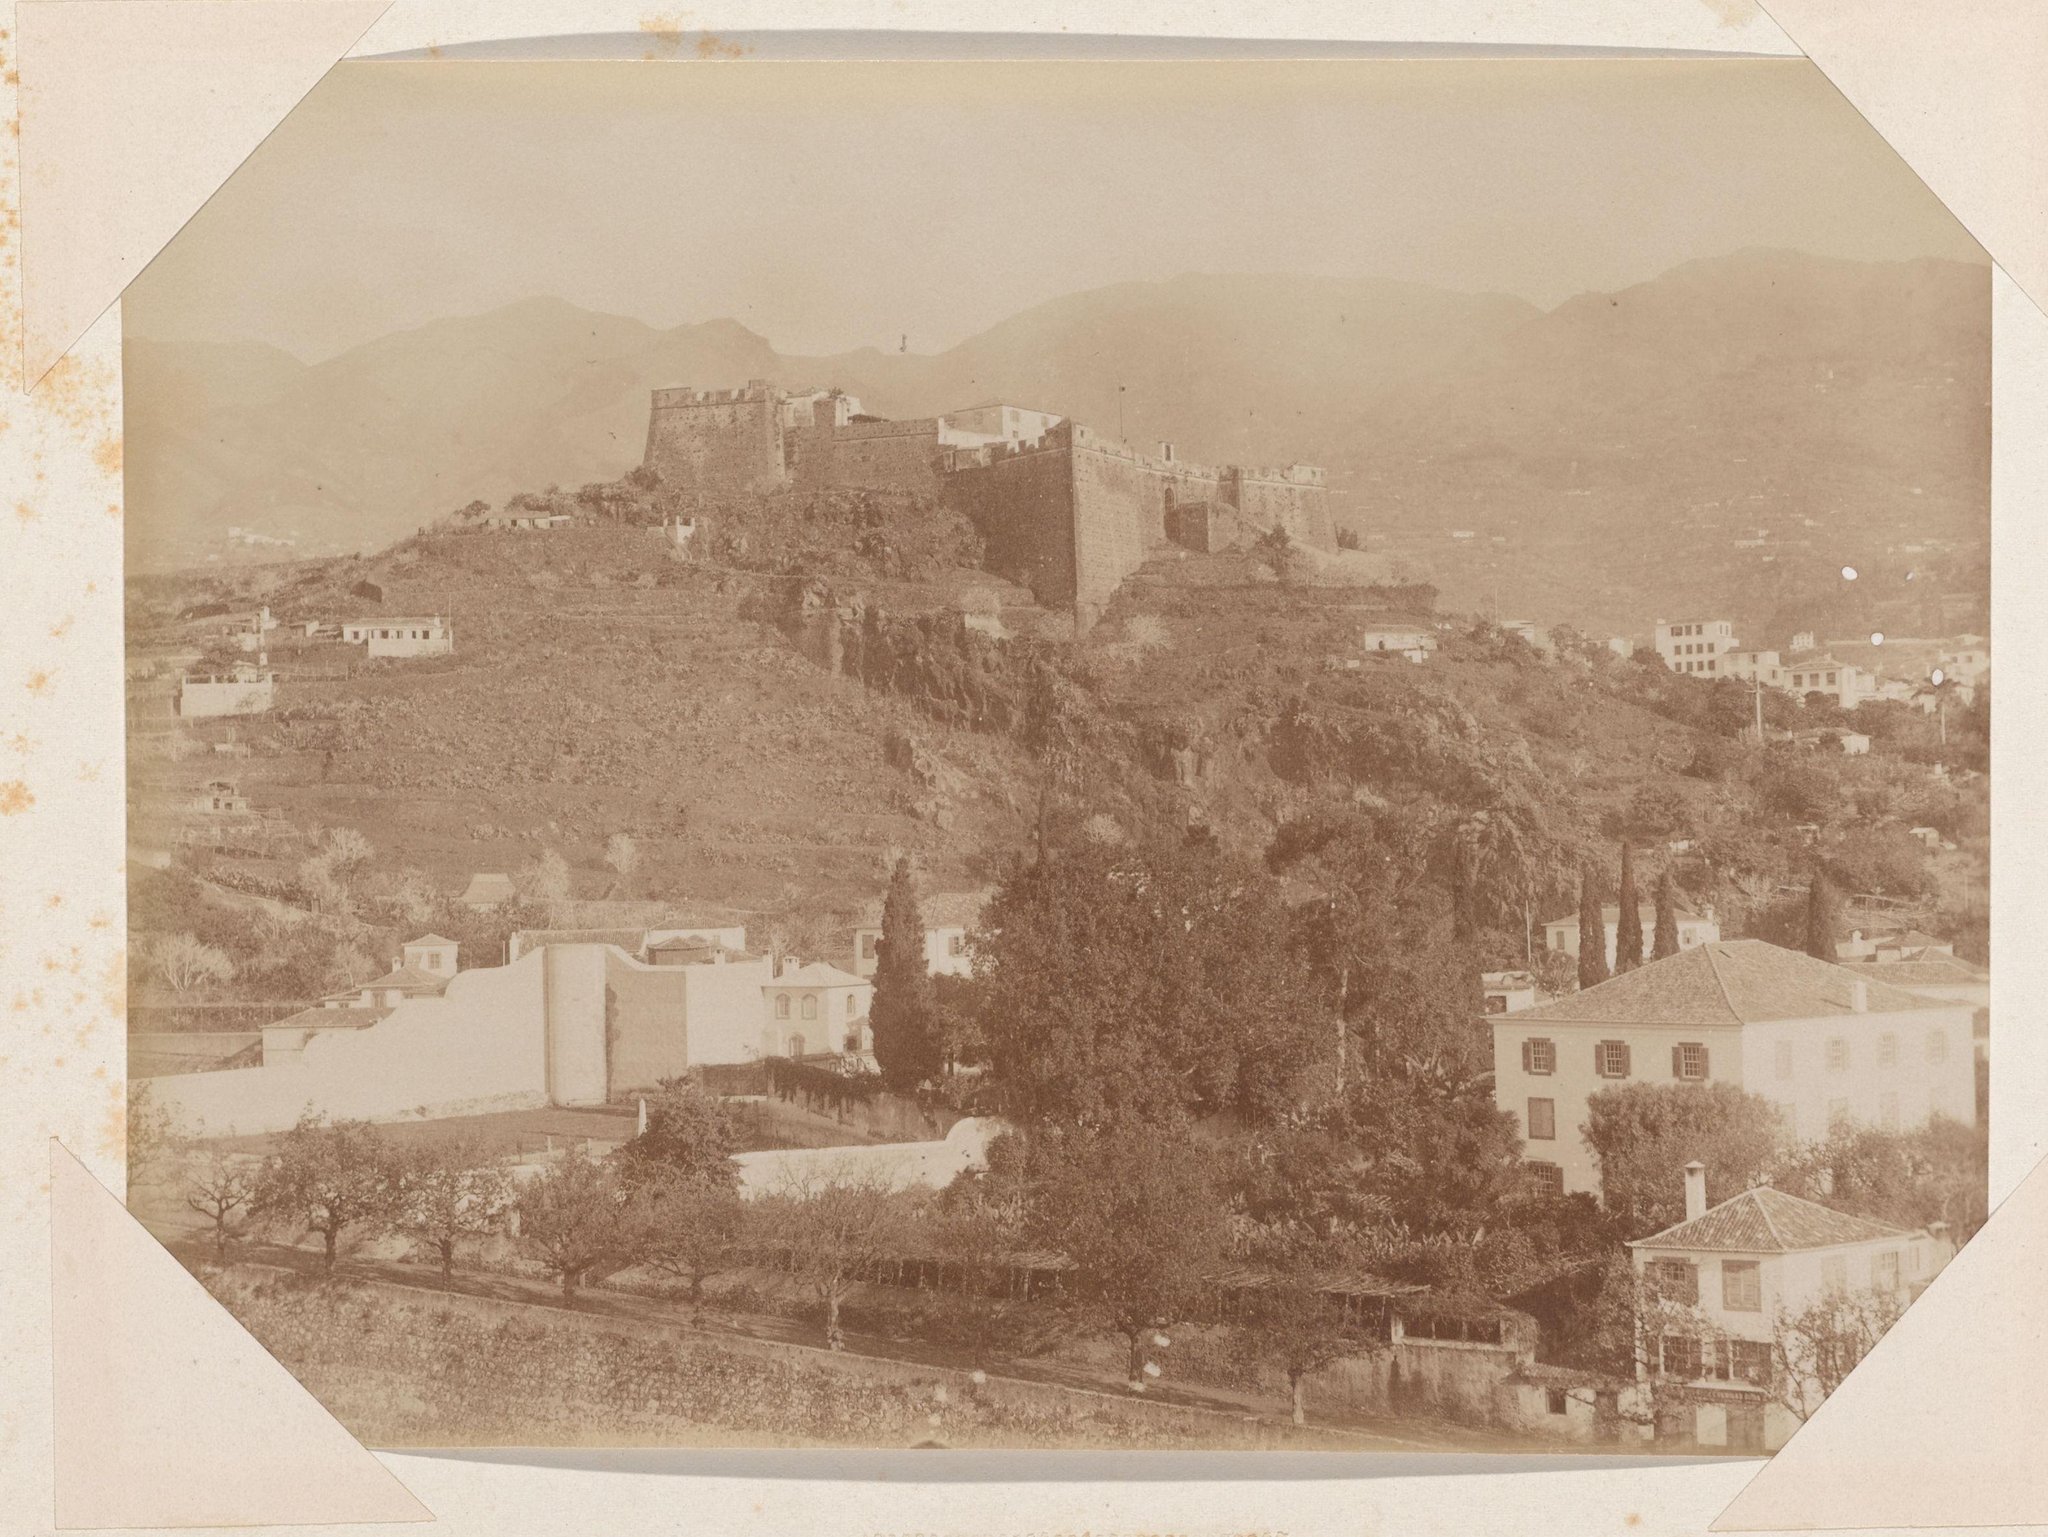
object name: photograph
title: Madeira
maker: Anonymous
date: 1885-1910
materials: paper, photographic support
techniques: albumen print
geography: madeira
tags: fortress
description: Onderdeel van Album met 191 foto's van een reis naar en door Zuid-Afrika.